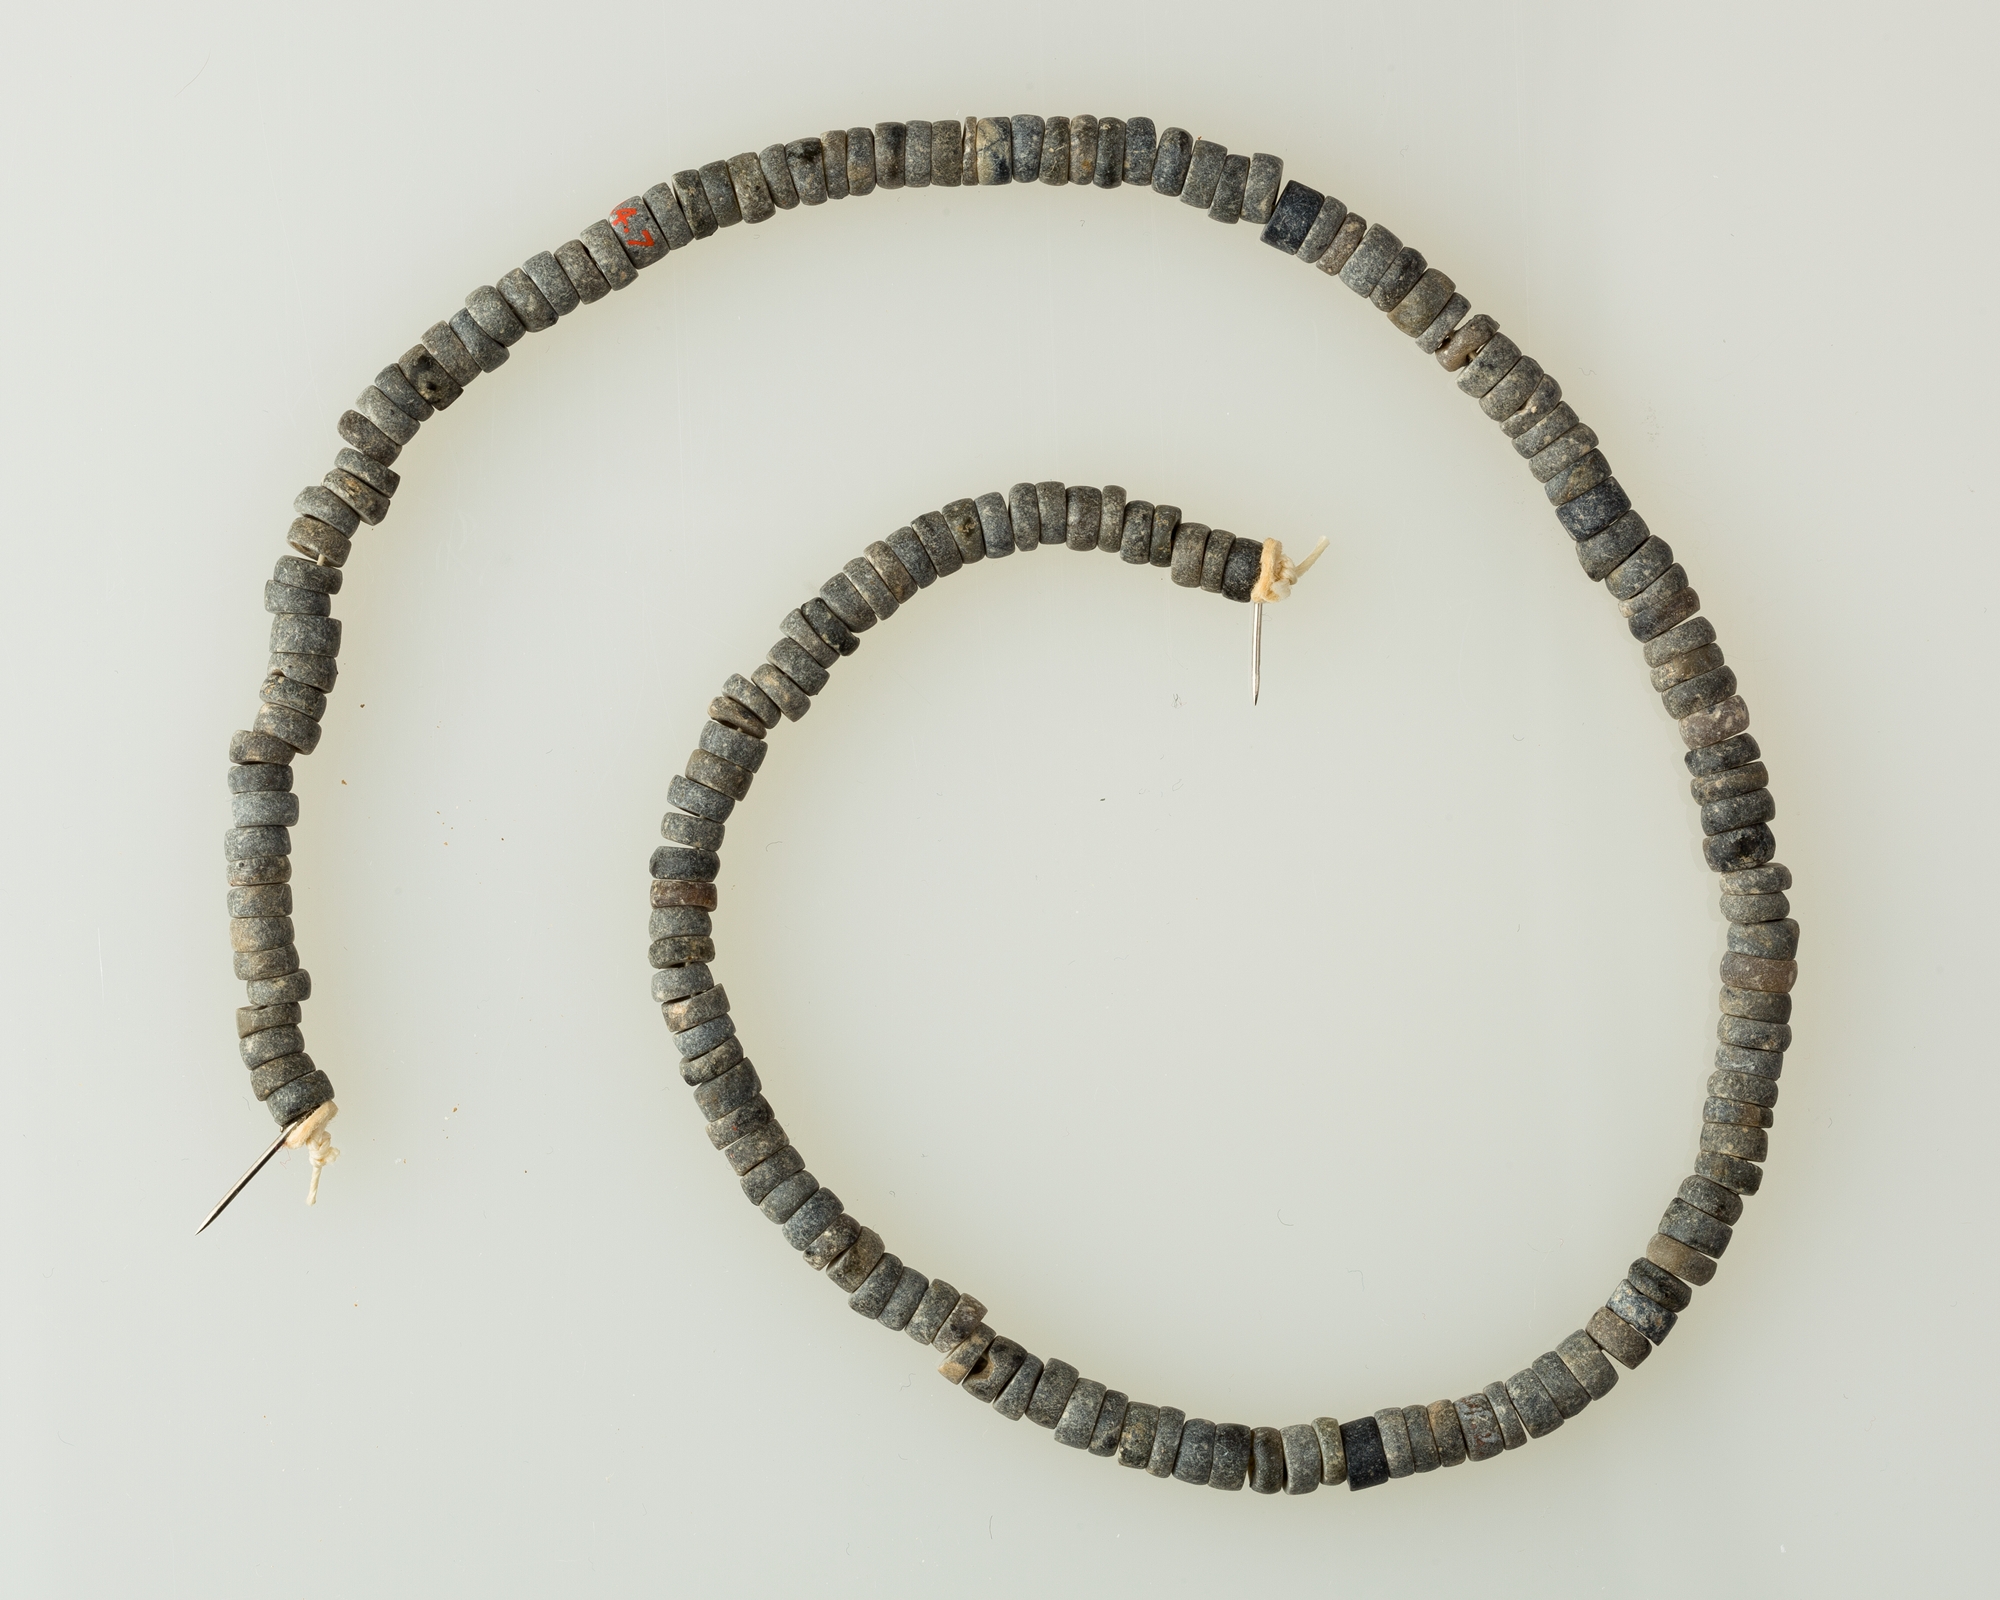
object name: bead, string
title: String of beads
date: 3650-2960 BCE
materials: stone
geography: egypt